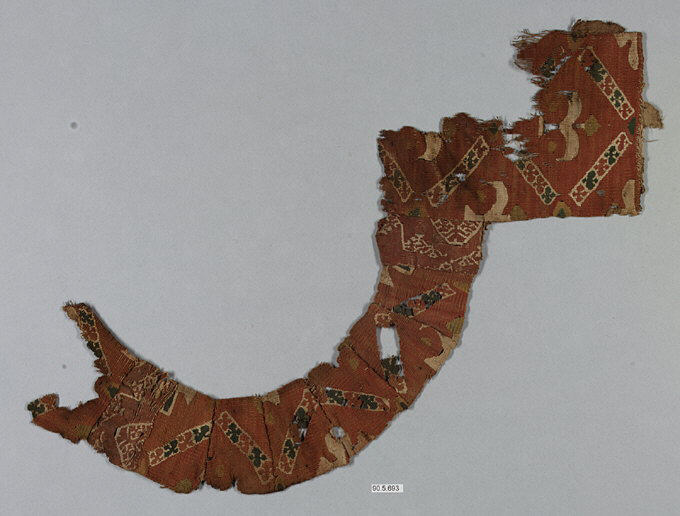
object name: textile fragment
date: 501-600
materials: linen, wool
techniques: weave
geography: egypt